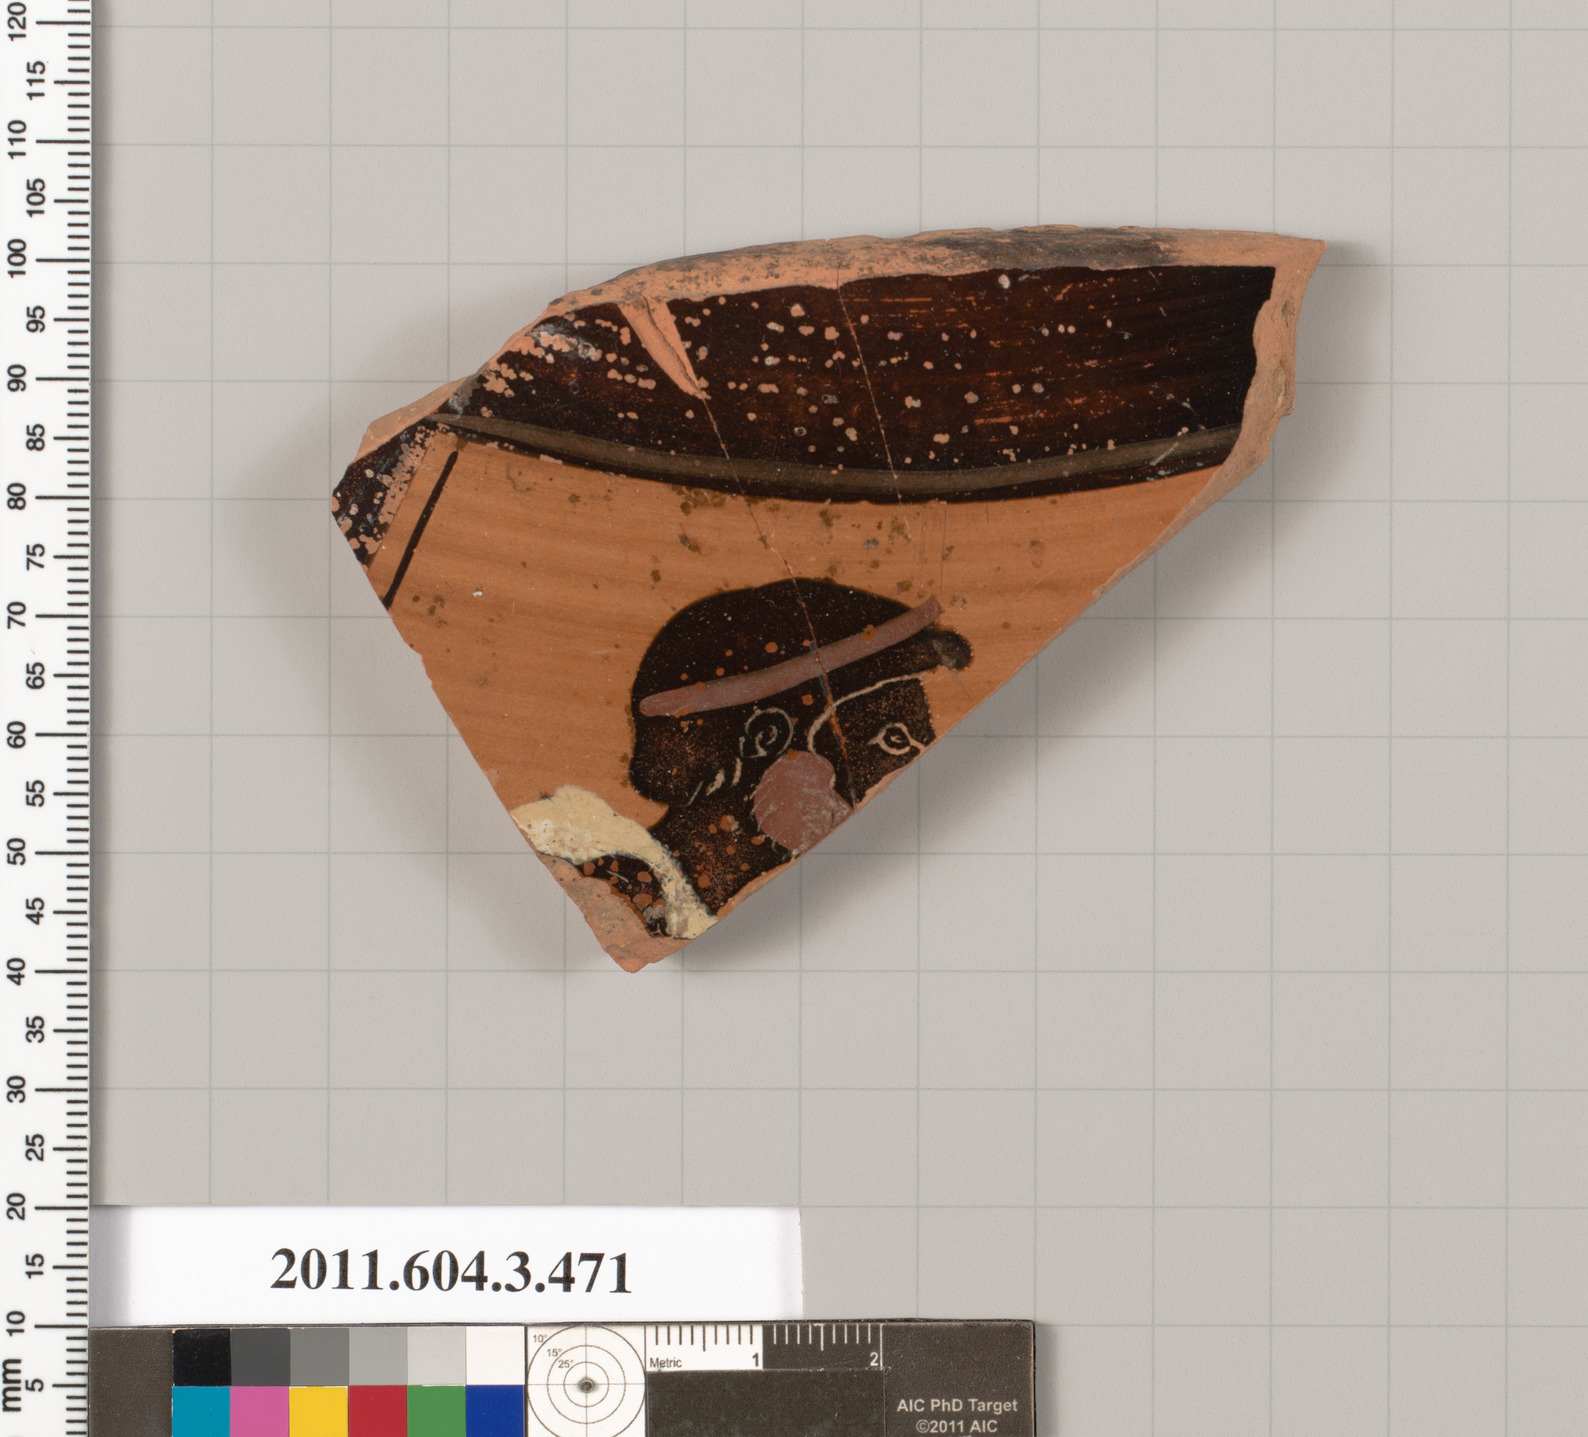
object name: panathenaic prize amphora fragment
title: Terracotta fragment of a Panathenaic prize amphora?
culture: greek, attic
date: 534-468 BCE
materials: terracotta